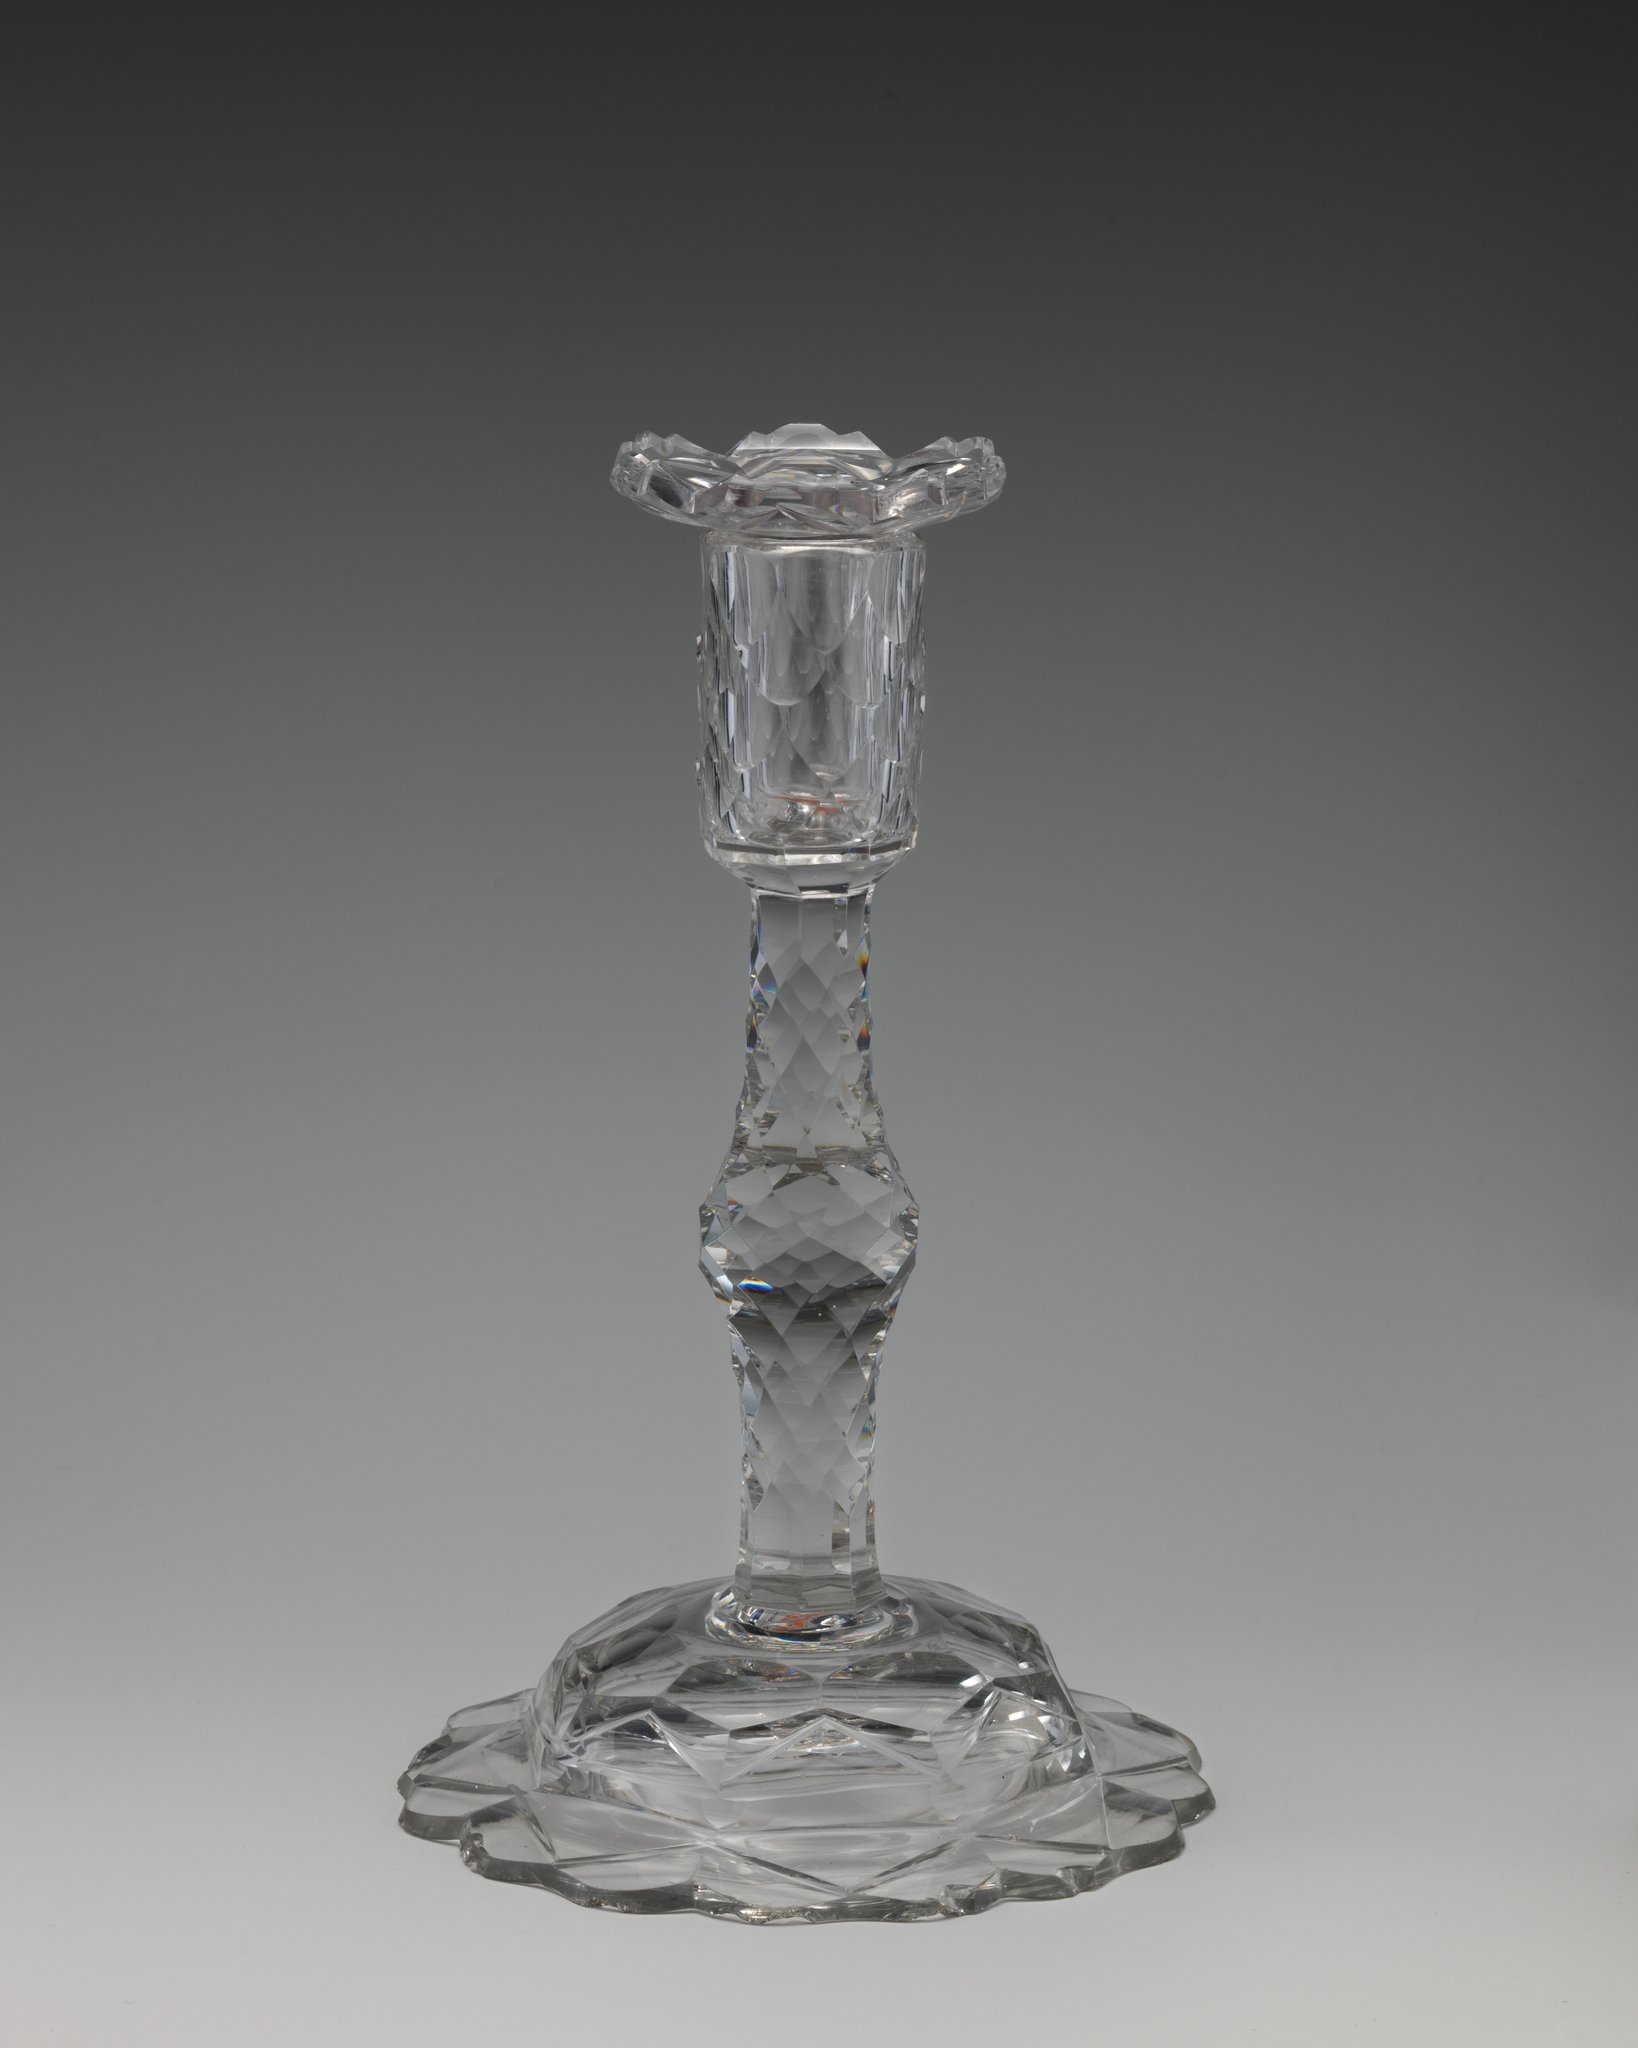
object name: candlestick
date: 1760-1770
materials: glass